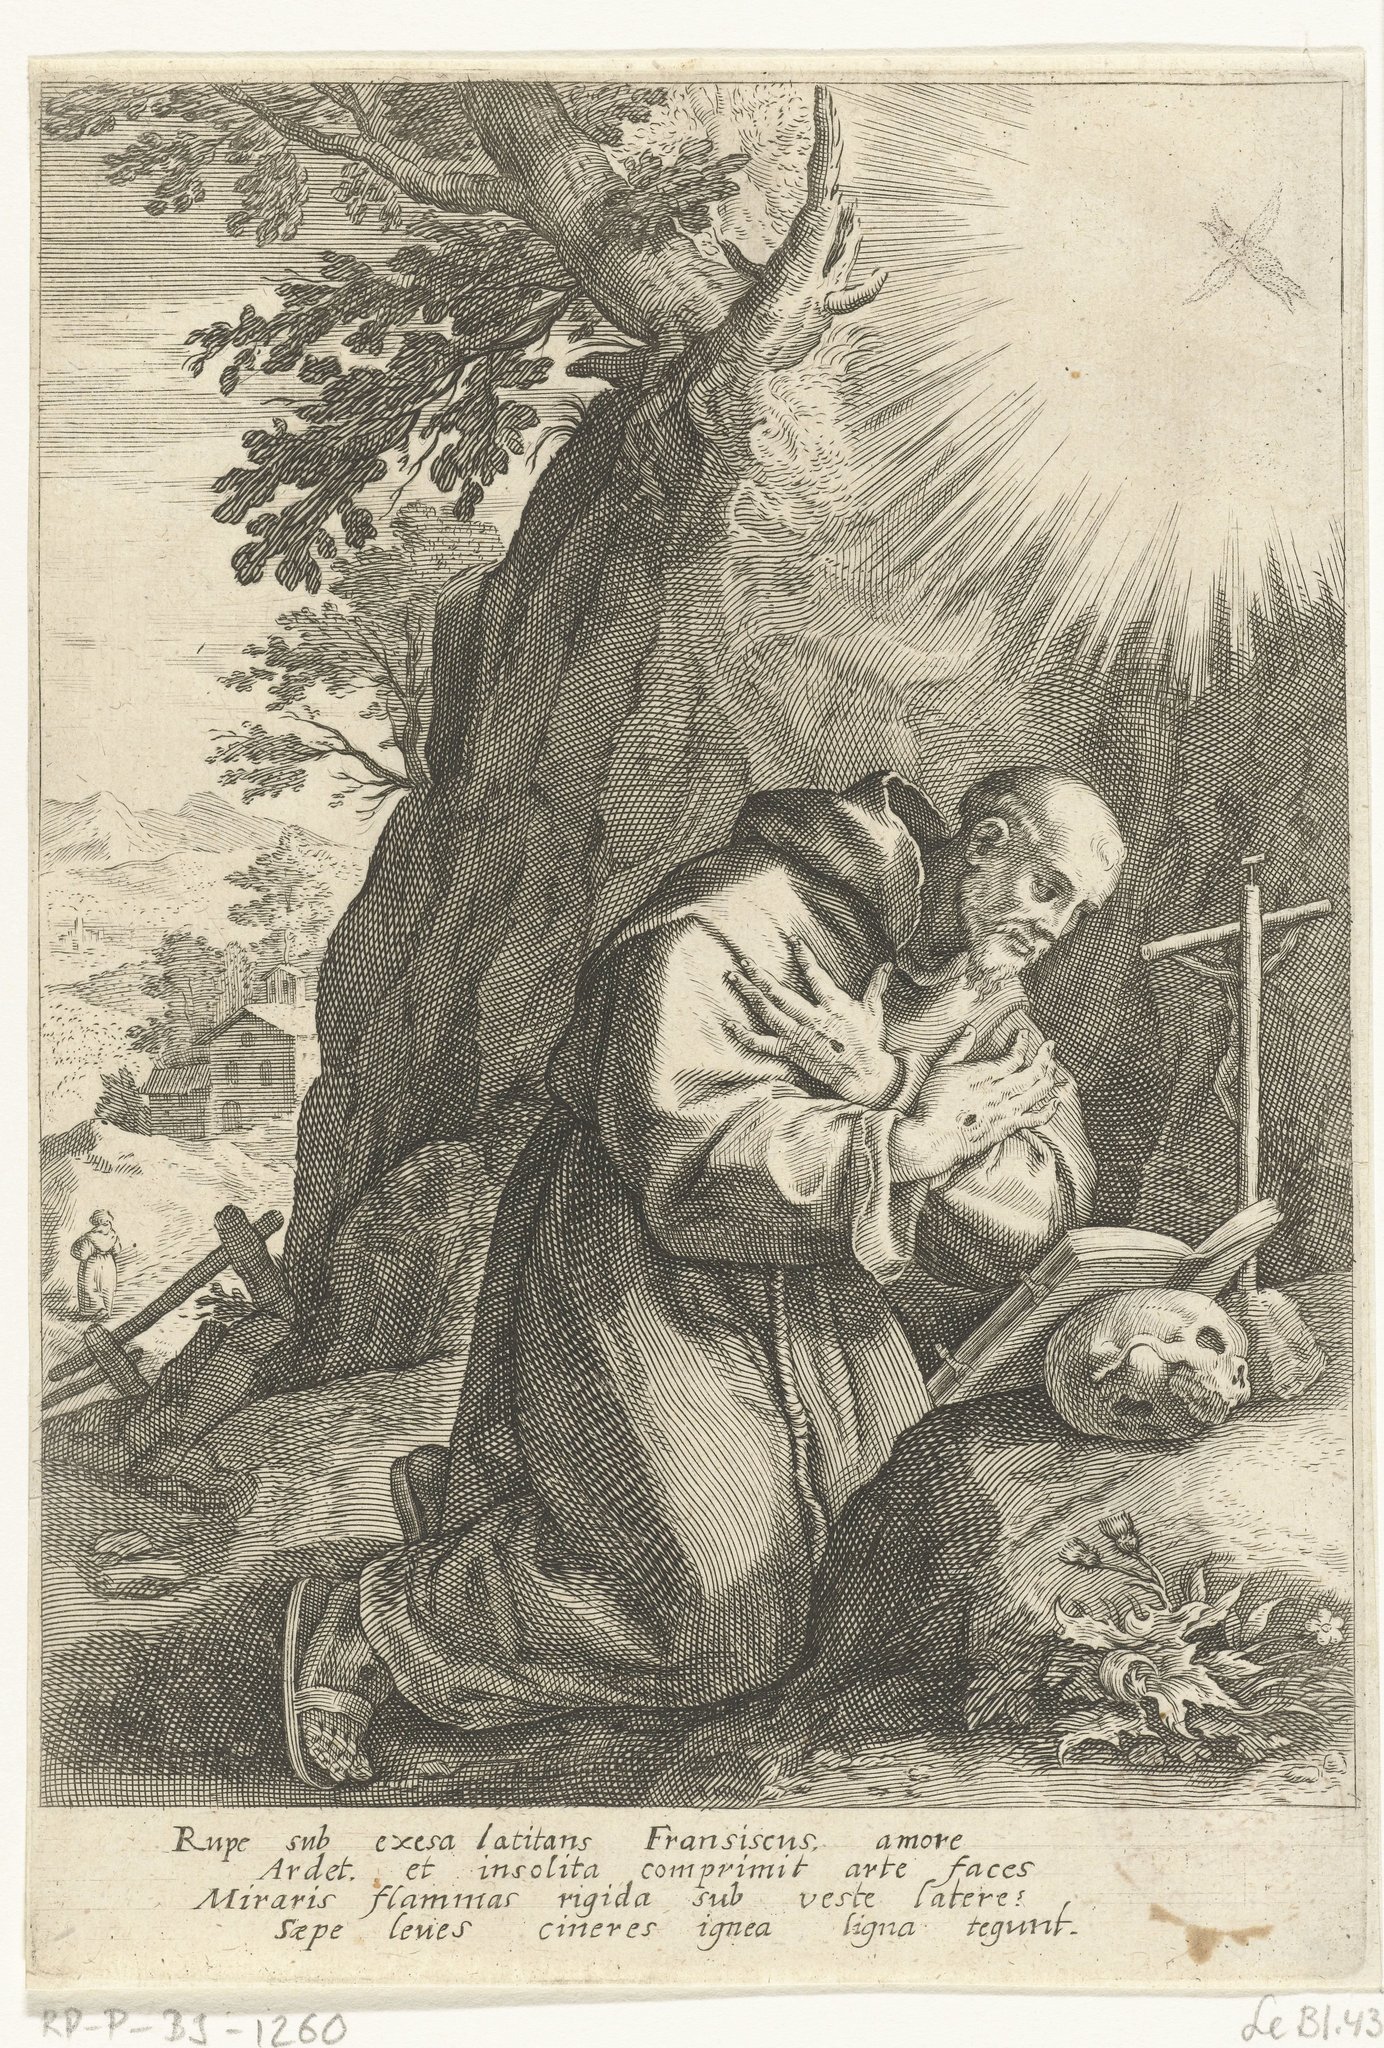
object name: print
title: De heilige Franciscus in de woestijn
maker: cornelis bloemaert (ii)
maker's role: draughtsman, print maker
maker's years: 1603-1692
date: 1633-1692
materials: paper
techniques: engraving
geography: rome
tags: founder of the order of friars minor (franciscans), francis(cus) of assisi; possible attributes: book, crucifix, lily, skull, stigmata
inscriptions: collector's mark: Lugt 240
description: Franciscus van Assisi is hier knielend afgebeeld met een aantal van zijn attributen: de stigmata op handen en voeten, een crucifix, een schedel en een boek.